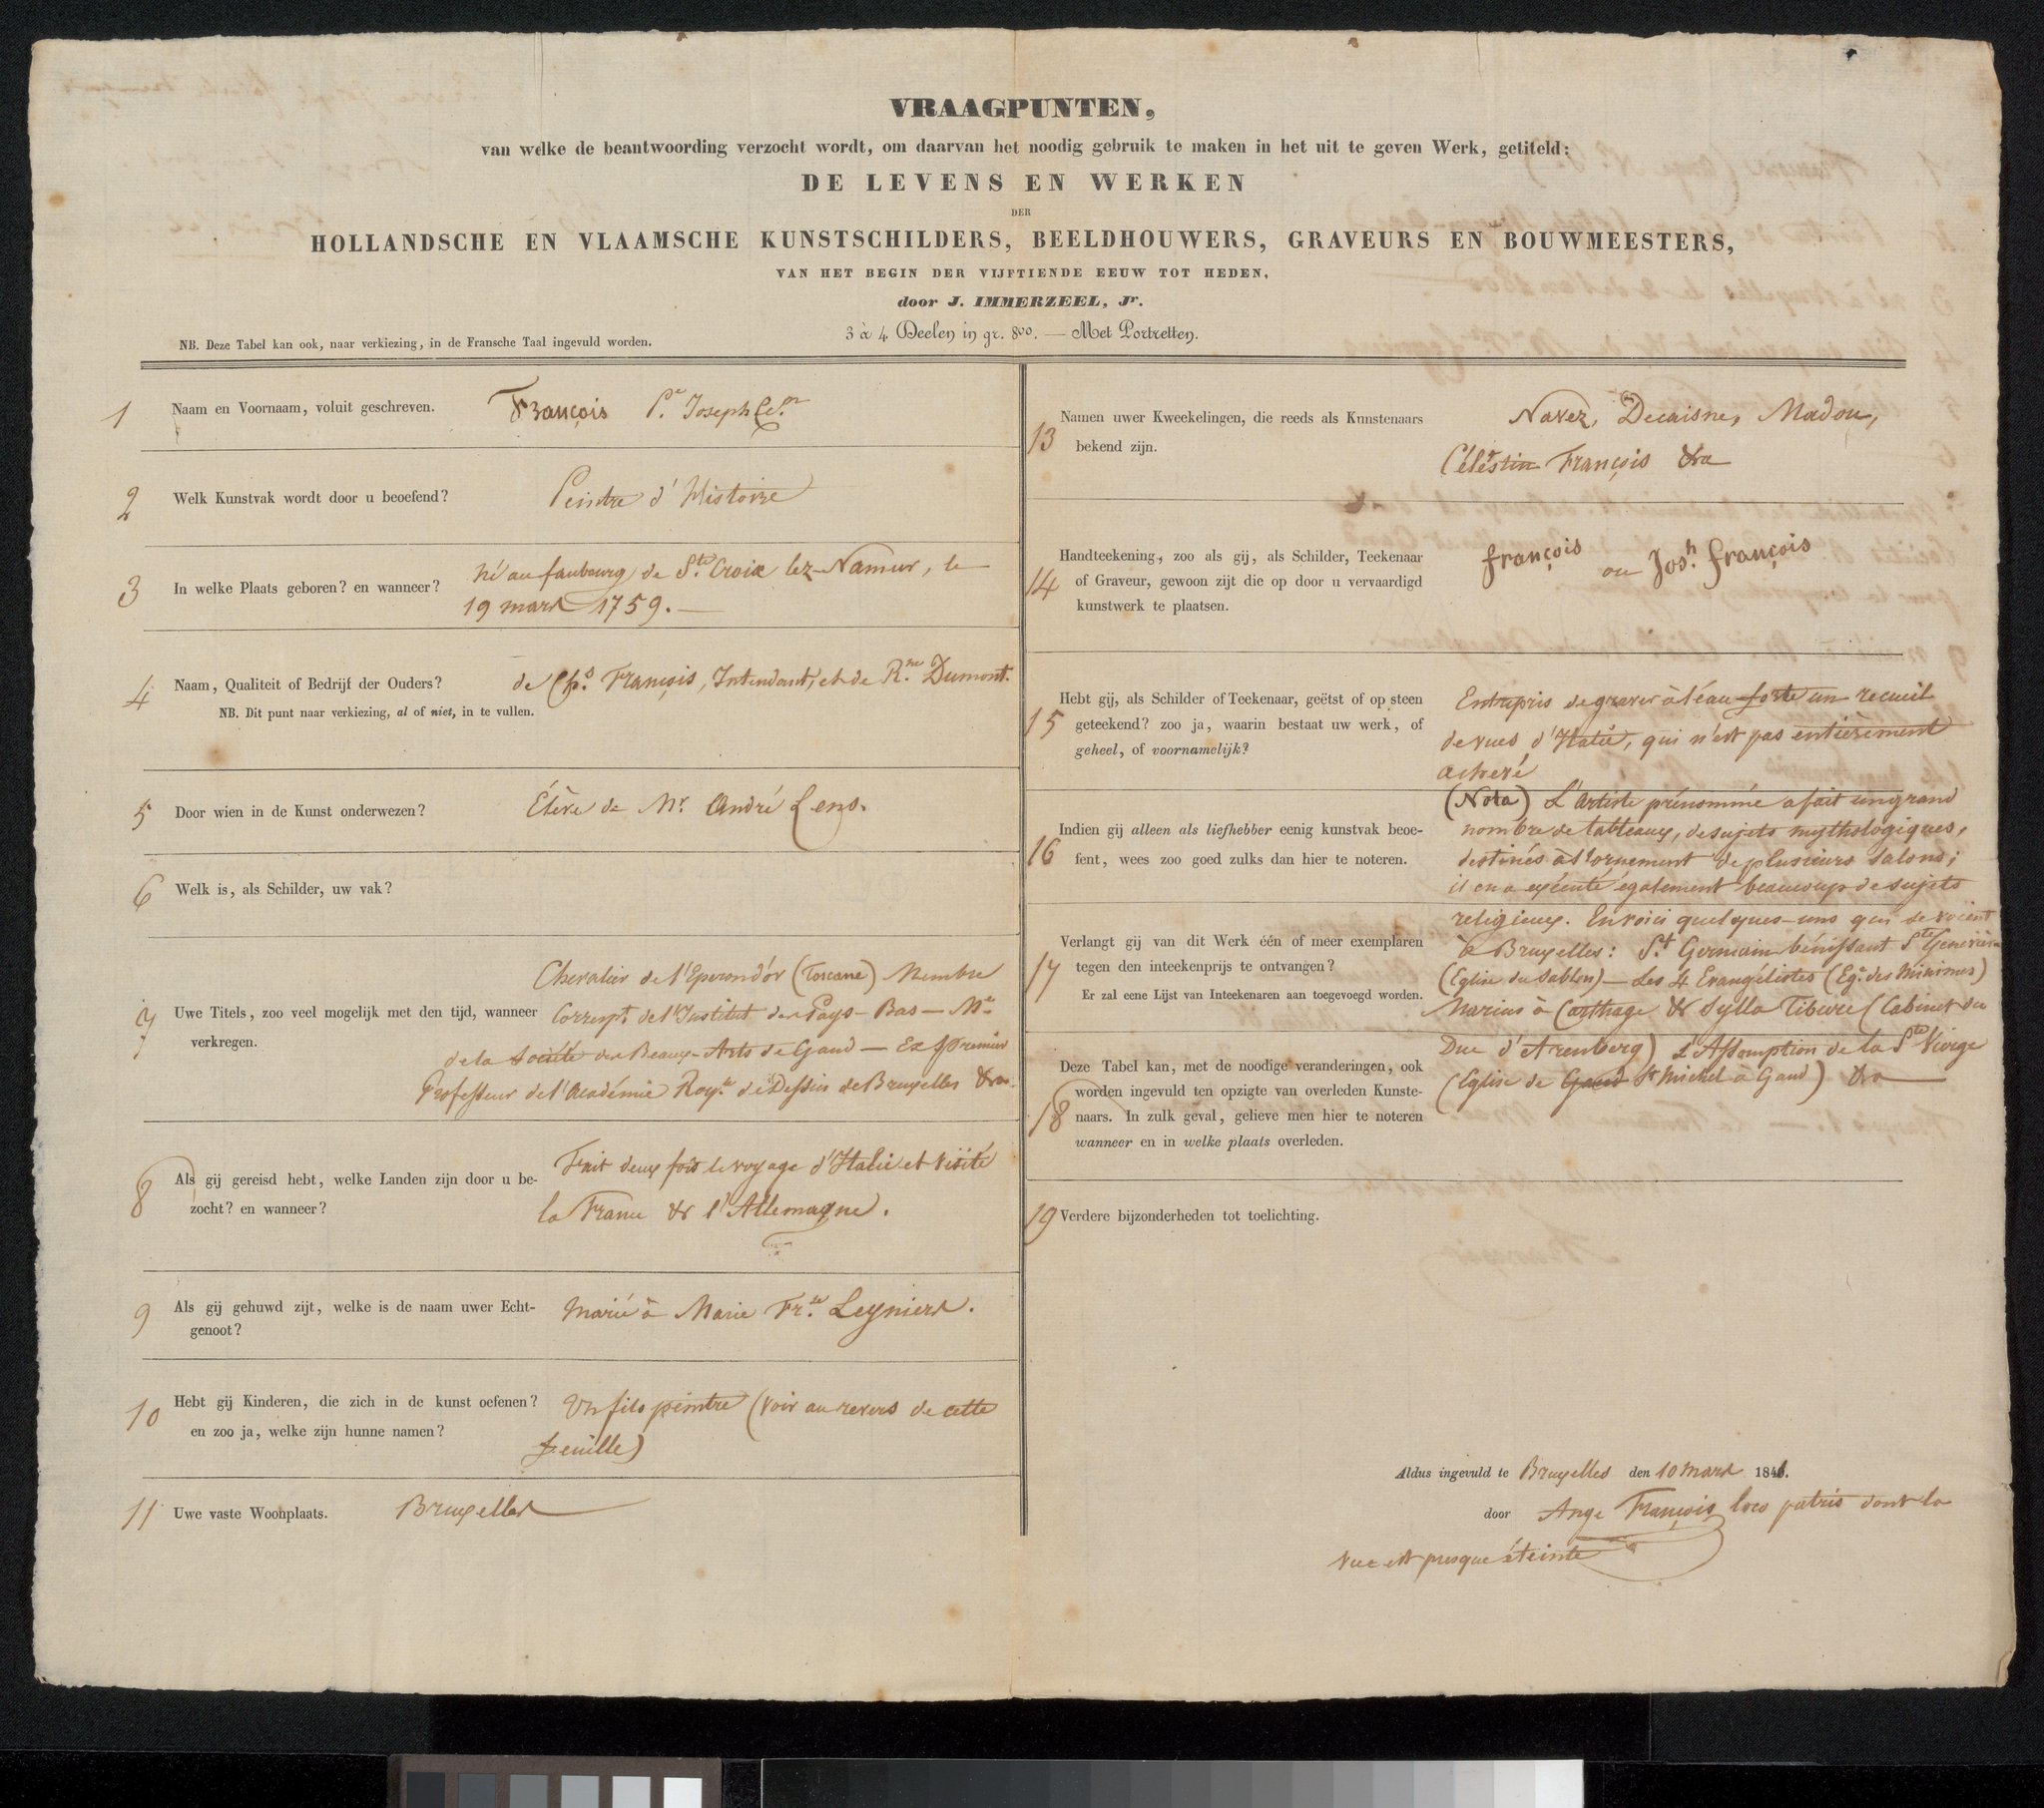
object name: questionnaire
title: Enquêteformulier betreffende Joseph François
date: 1841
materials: ink, paper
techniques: pen, printing, writing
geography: brussels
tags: brussels, draughtsman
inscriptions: inscription: ‘Vraagpunten,/ van welke de beantwoording verzocht wordt, om daarvan het noodig gebruik te maken in het uit te geven Werk, getiteld: De levens en werken/ der Hollandsche en Vlaamsche kunstschilders, beeldhouwers,/ graveurs en bouwmeesters, van het begin der vijftiende eeuw tot heden/ door J. Immerzeel, Jr.’, watermark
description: Opgenomen in: Immerzeel, J. Jr., De levens en werken der Hollandsche en Vlaamsche kunstschilders, beeldhouwers, graveurs en bouwmeesters, van het begin der vijftiende eeuw tot heden, Amsterdam: J.C. van Kesteren, 1842-1843.